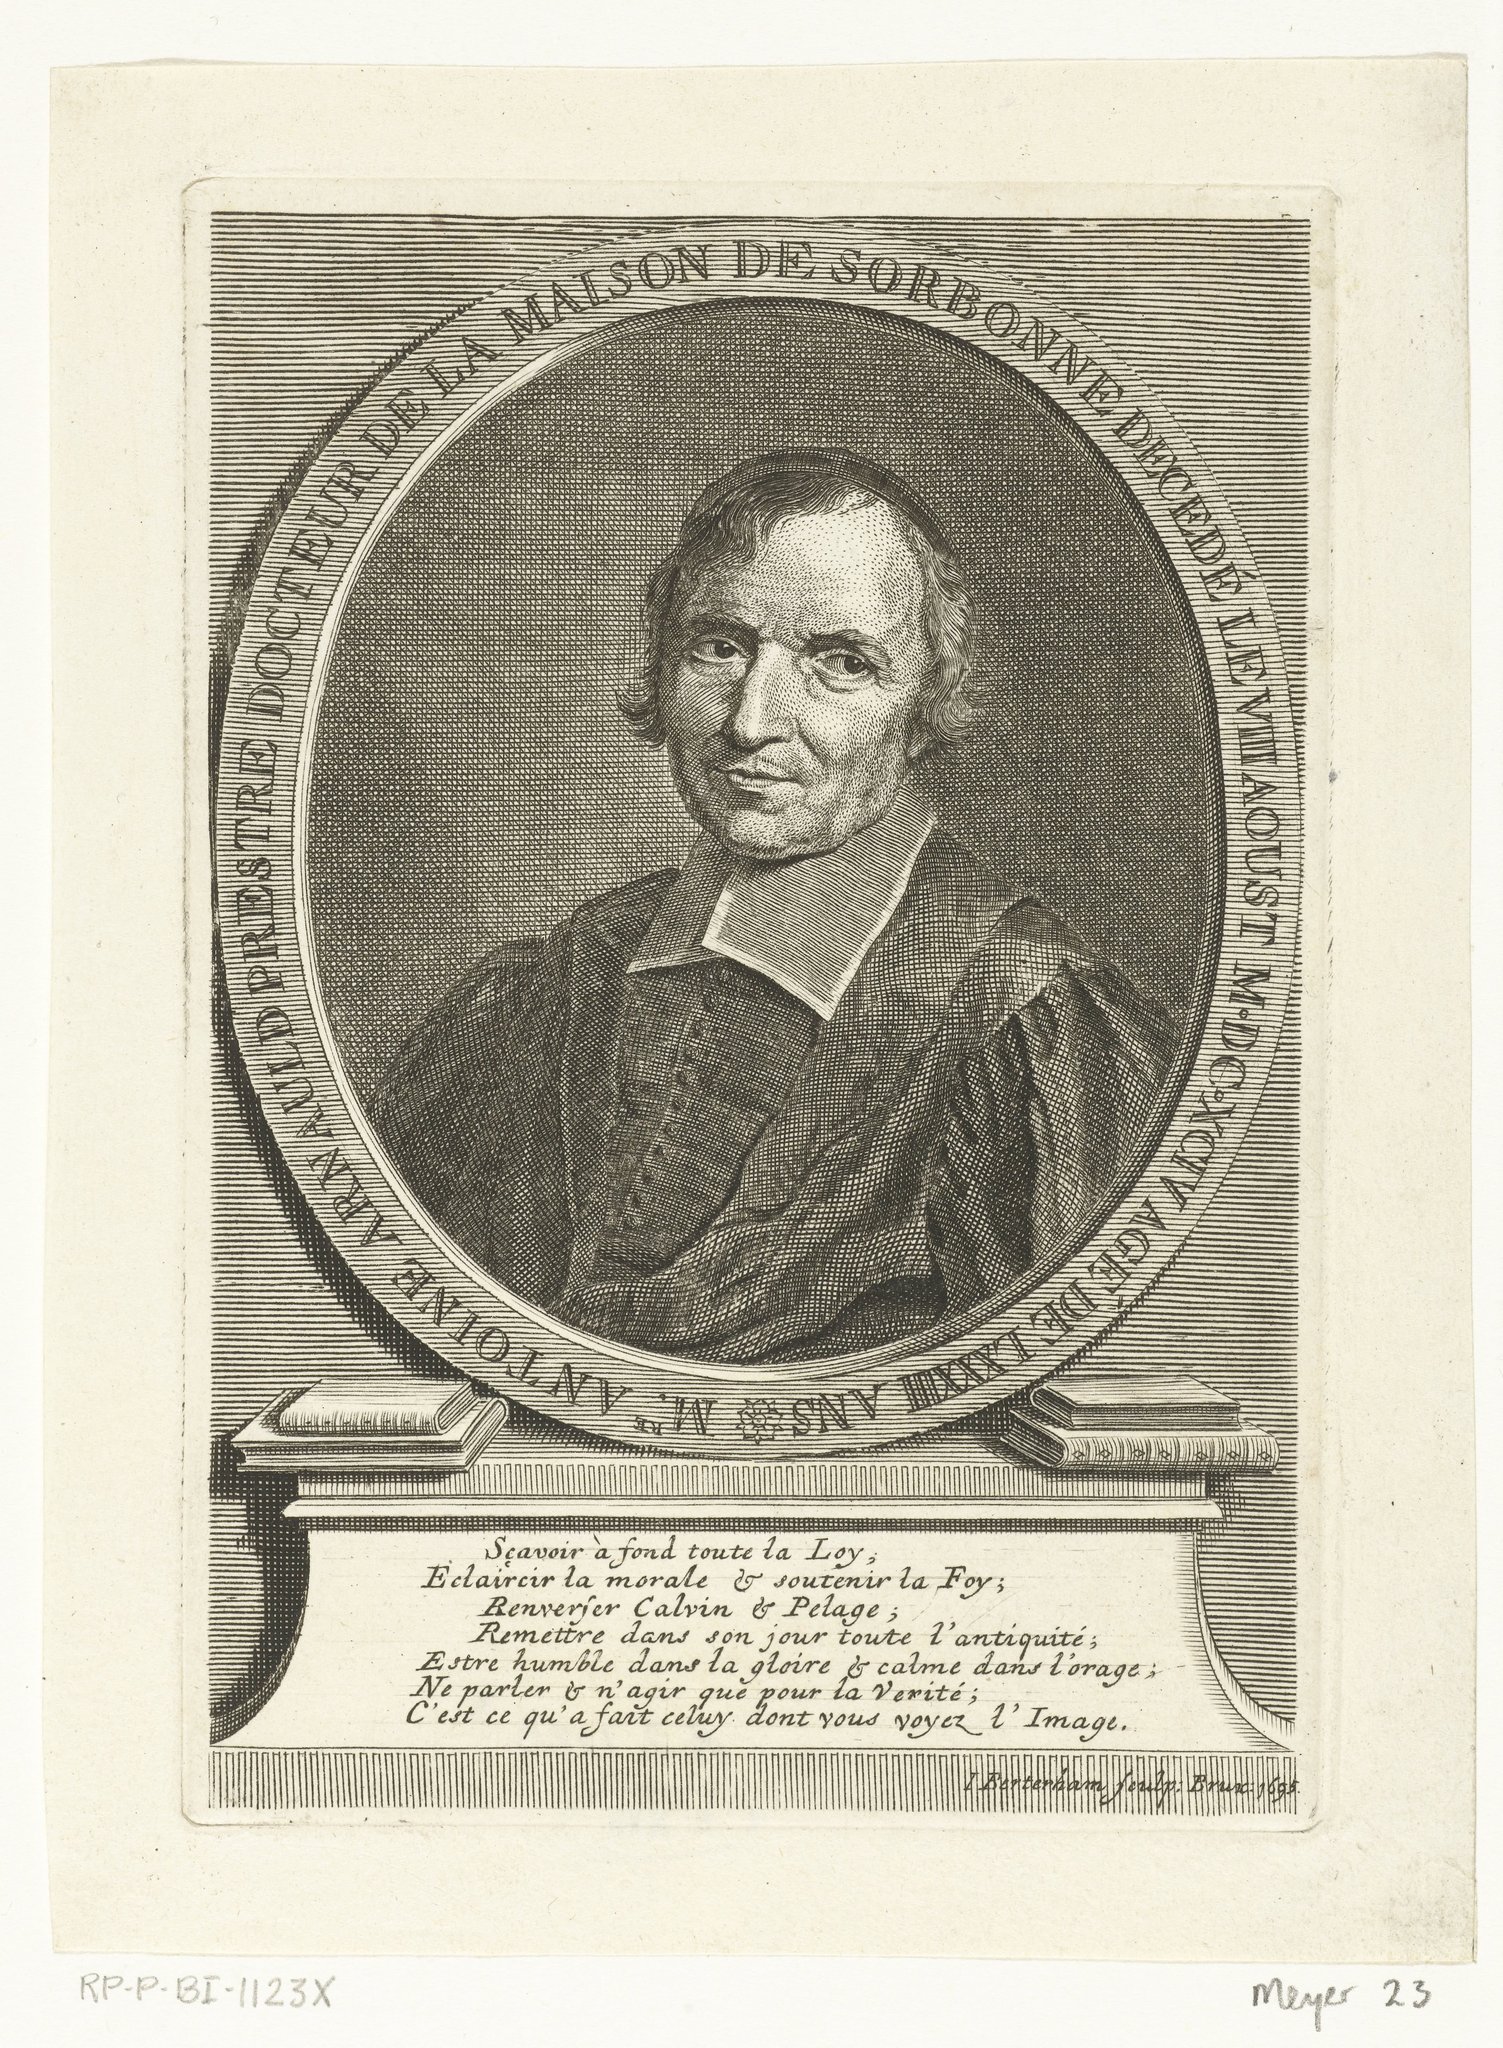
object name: print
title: Portret van hoogleraar theologie Antoine Arnauld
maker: jan baptist berterham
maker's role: print maker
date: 1695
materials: paper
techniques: engraving, etching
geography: brussels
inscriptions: collector's mark: Lugt 2228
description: Portret van hoogleraar theologie Antoine Arnauld op 83-jarige leeftijd in ovale omlijsting. Het gedicht op de sokkel spreekt lovend over deze man.